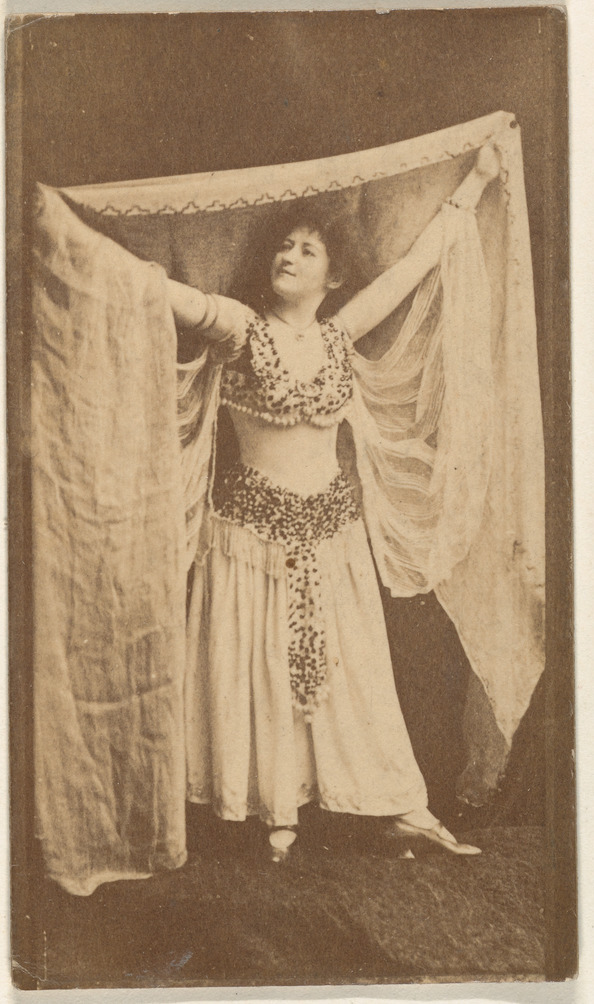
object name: photograph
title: Dancer holding shawl above head, from the Actresses series (N668)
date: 1888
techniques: albumen silver print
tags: women,dancers